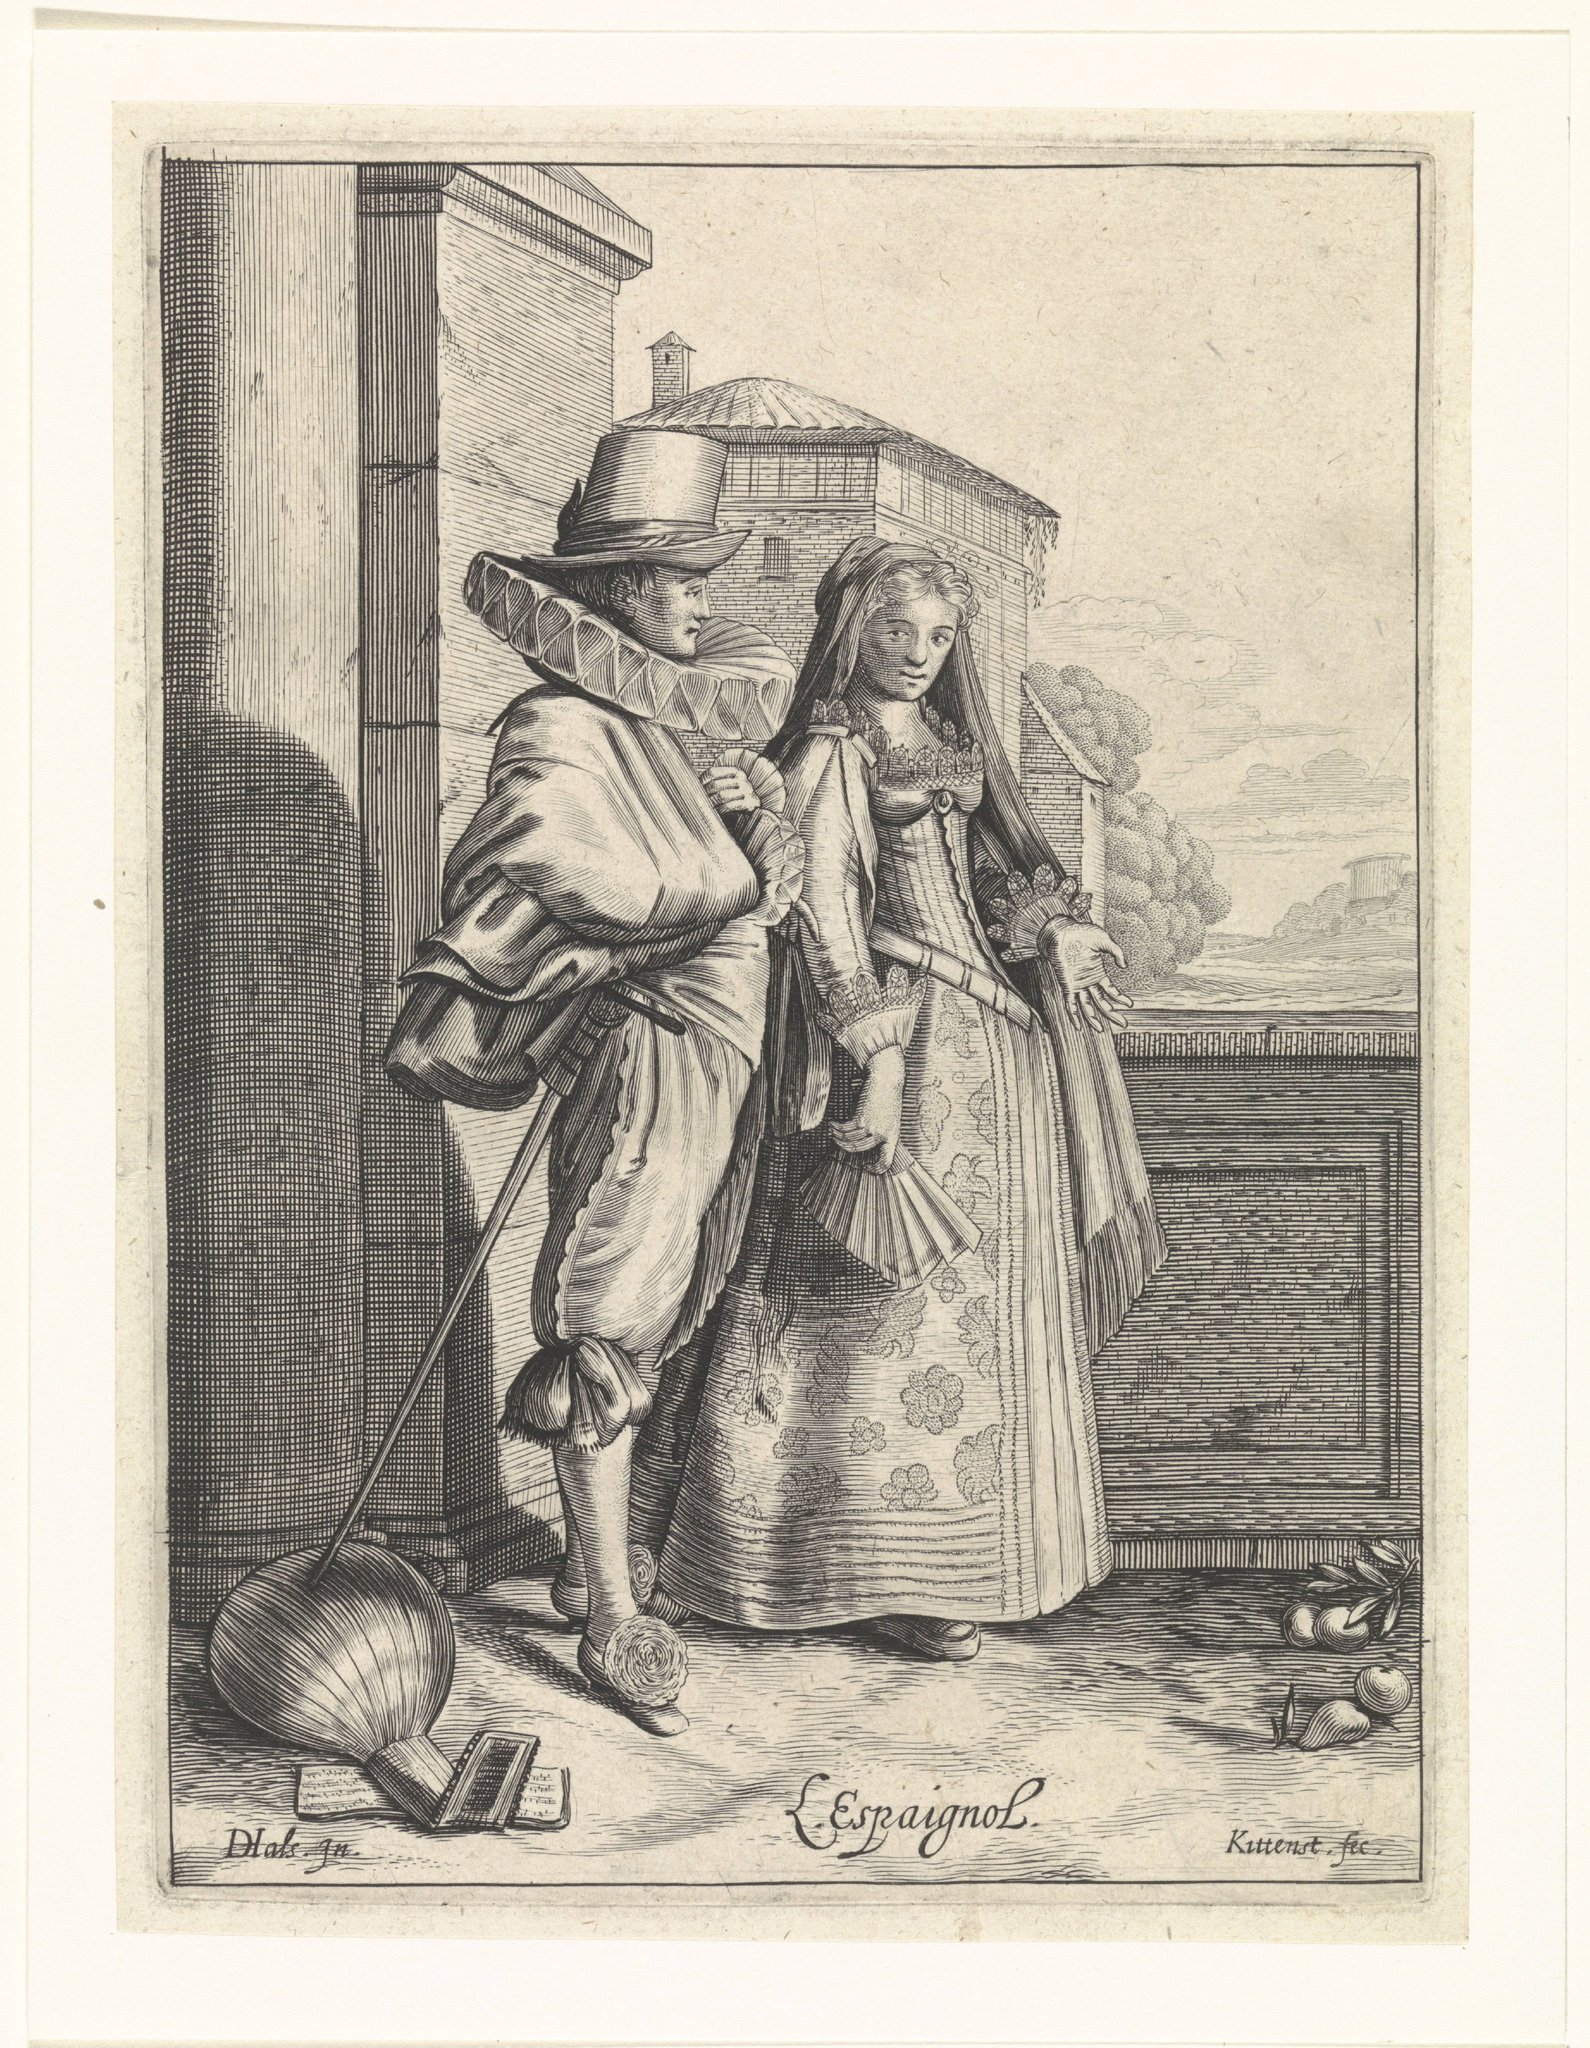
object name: costume print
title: L'Espaignol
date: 1615-1625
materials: paper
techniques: engraving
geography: netherlands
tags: neck-gear ~ clothing (with name) (+ men's clothes), veil (+ women's clothes), europeans: spaniards (+ costume), coat (+ men's clothes), head-gear: hat (+ men's clothes), clothes, costume (+ women's clothes), hacking and thrusting weapons: sword, sleeves: cuffs (+ women's clothes), dress, gown (+ women's clothes), shoes, sandals (+ men's clothes), clothes, costume (+ men's clothes), folk costume, regional costume, lute, and special forms of lute, e.g.: theorbo, trousers, breeches, etc. (breeches) (+ men's clothes), spain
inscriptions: collector's mark: Lugt 240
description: Kleding man: grof geplooide molensteenkraag en grof grplooide grote manchetten. Kniebroek met gestrikte kniebanden. Schoenen met kleine hak en grote rozet op de wreef. Kleding vrouw: Kapje met lange sluier, vierkant decolleté met kantversiering, manchetten met kant, puntvormig lijfje. Overkleed met passement en bloemmotieven. Ceintuur. Open vouwwaaier.